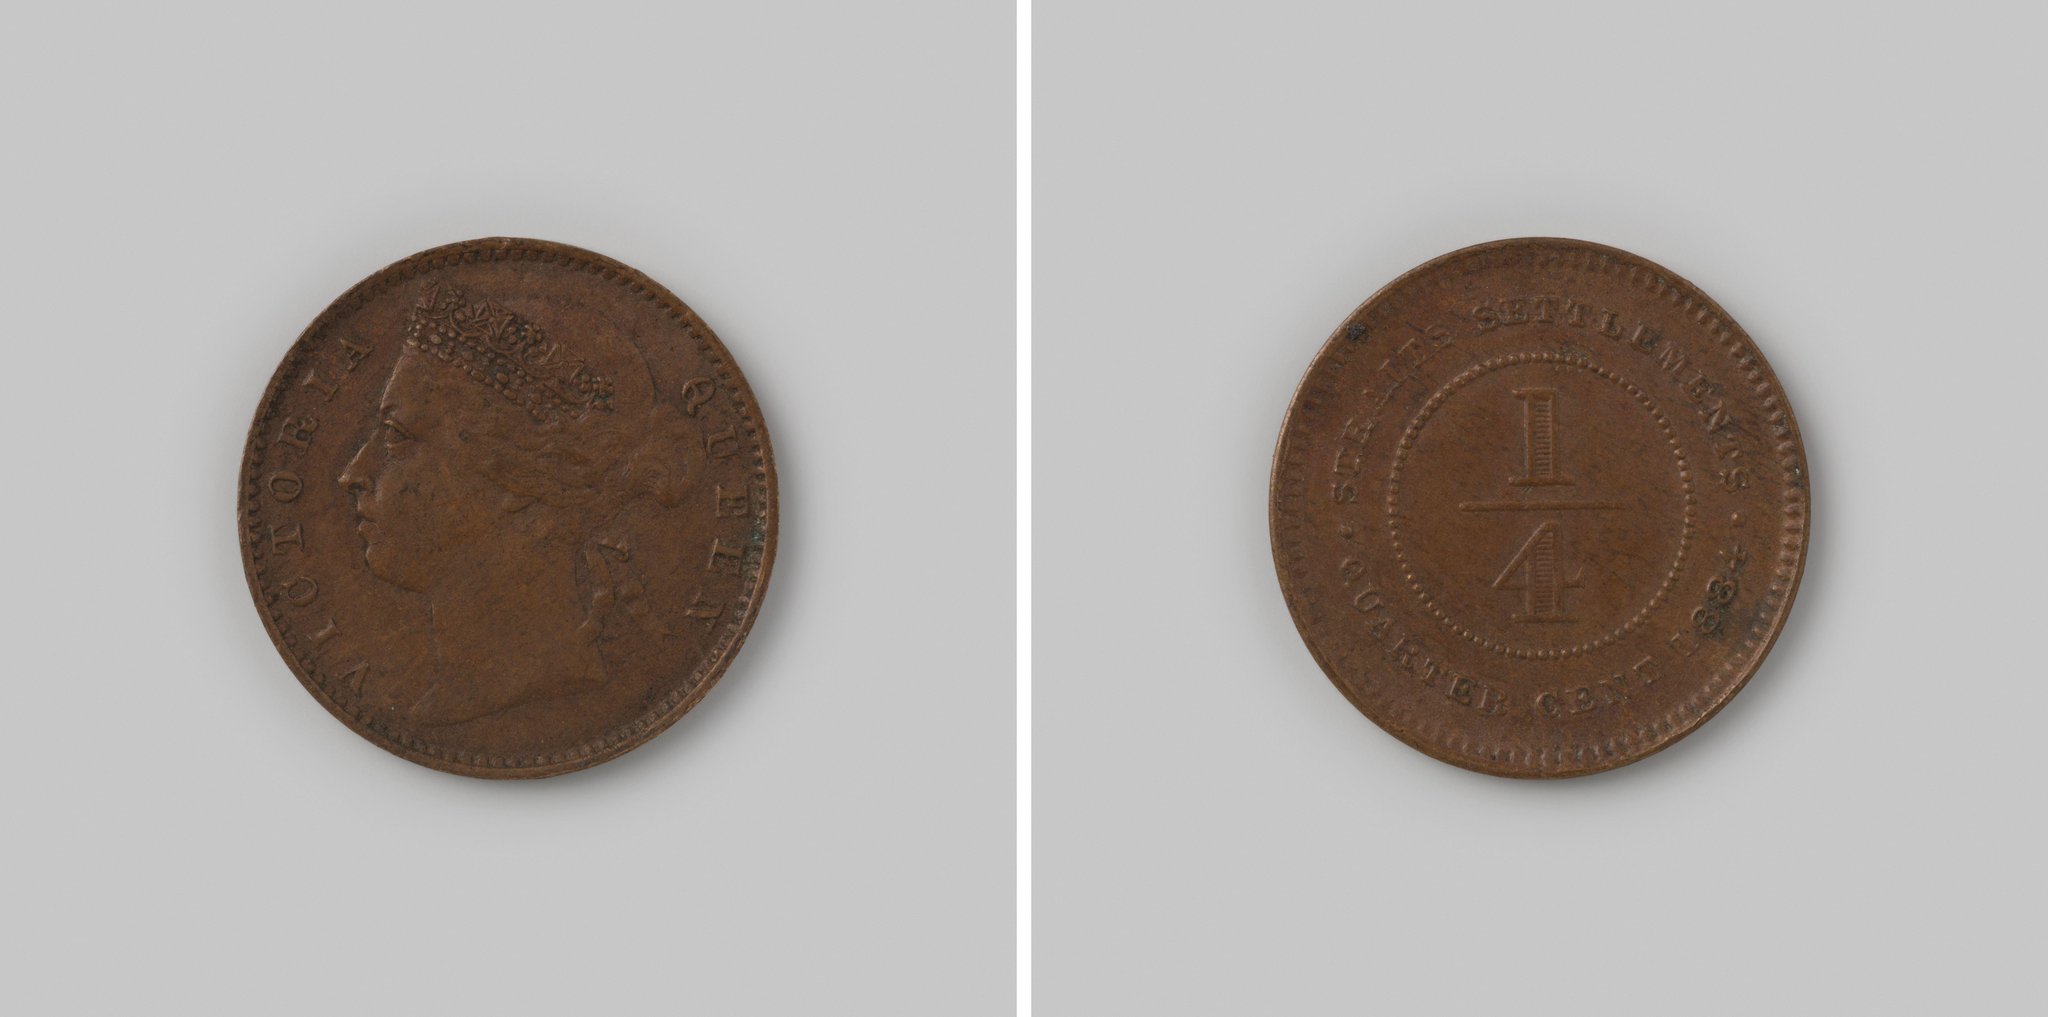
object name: coin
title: 1/4 cent uit de Straits Settlements van koningin Victoria, 1884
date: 1884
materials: copper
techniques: striking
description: Koperen munt. Voorzijde: gekroond hoofd van koningin Victoria naar links. Keerzijde: binnen parelcirkel waarde-aanduiding: 1/4.. In omschrift onderaan waarde-aanduiding: quarter cent met rechts daarvan jaartal. Gladde rand.